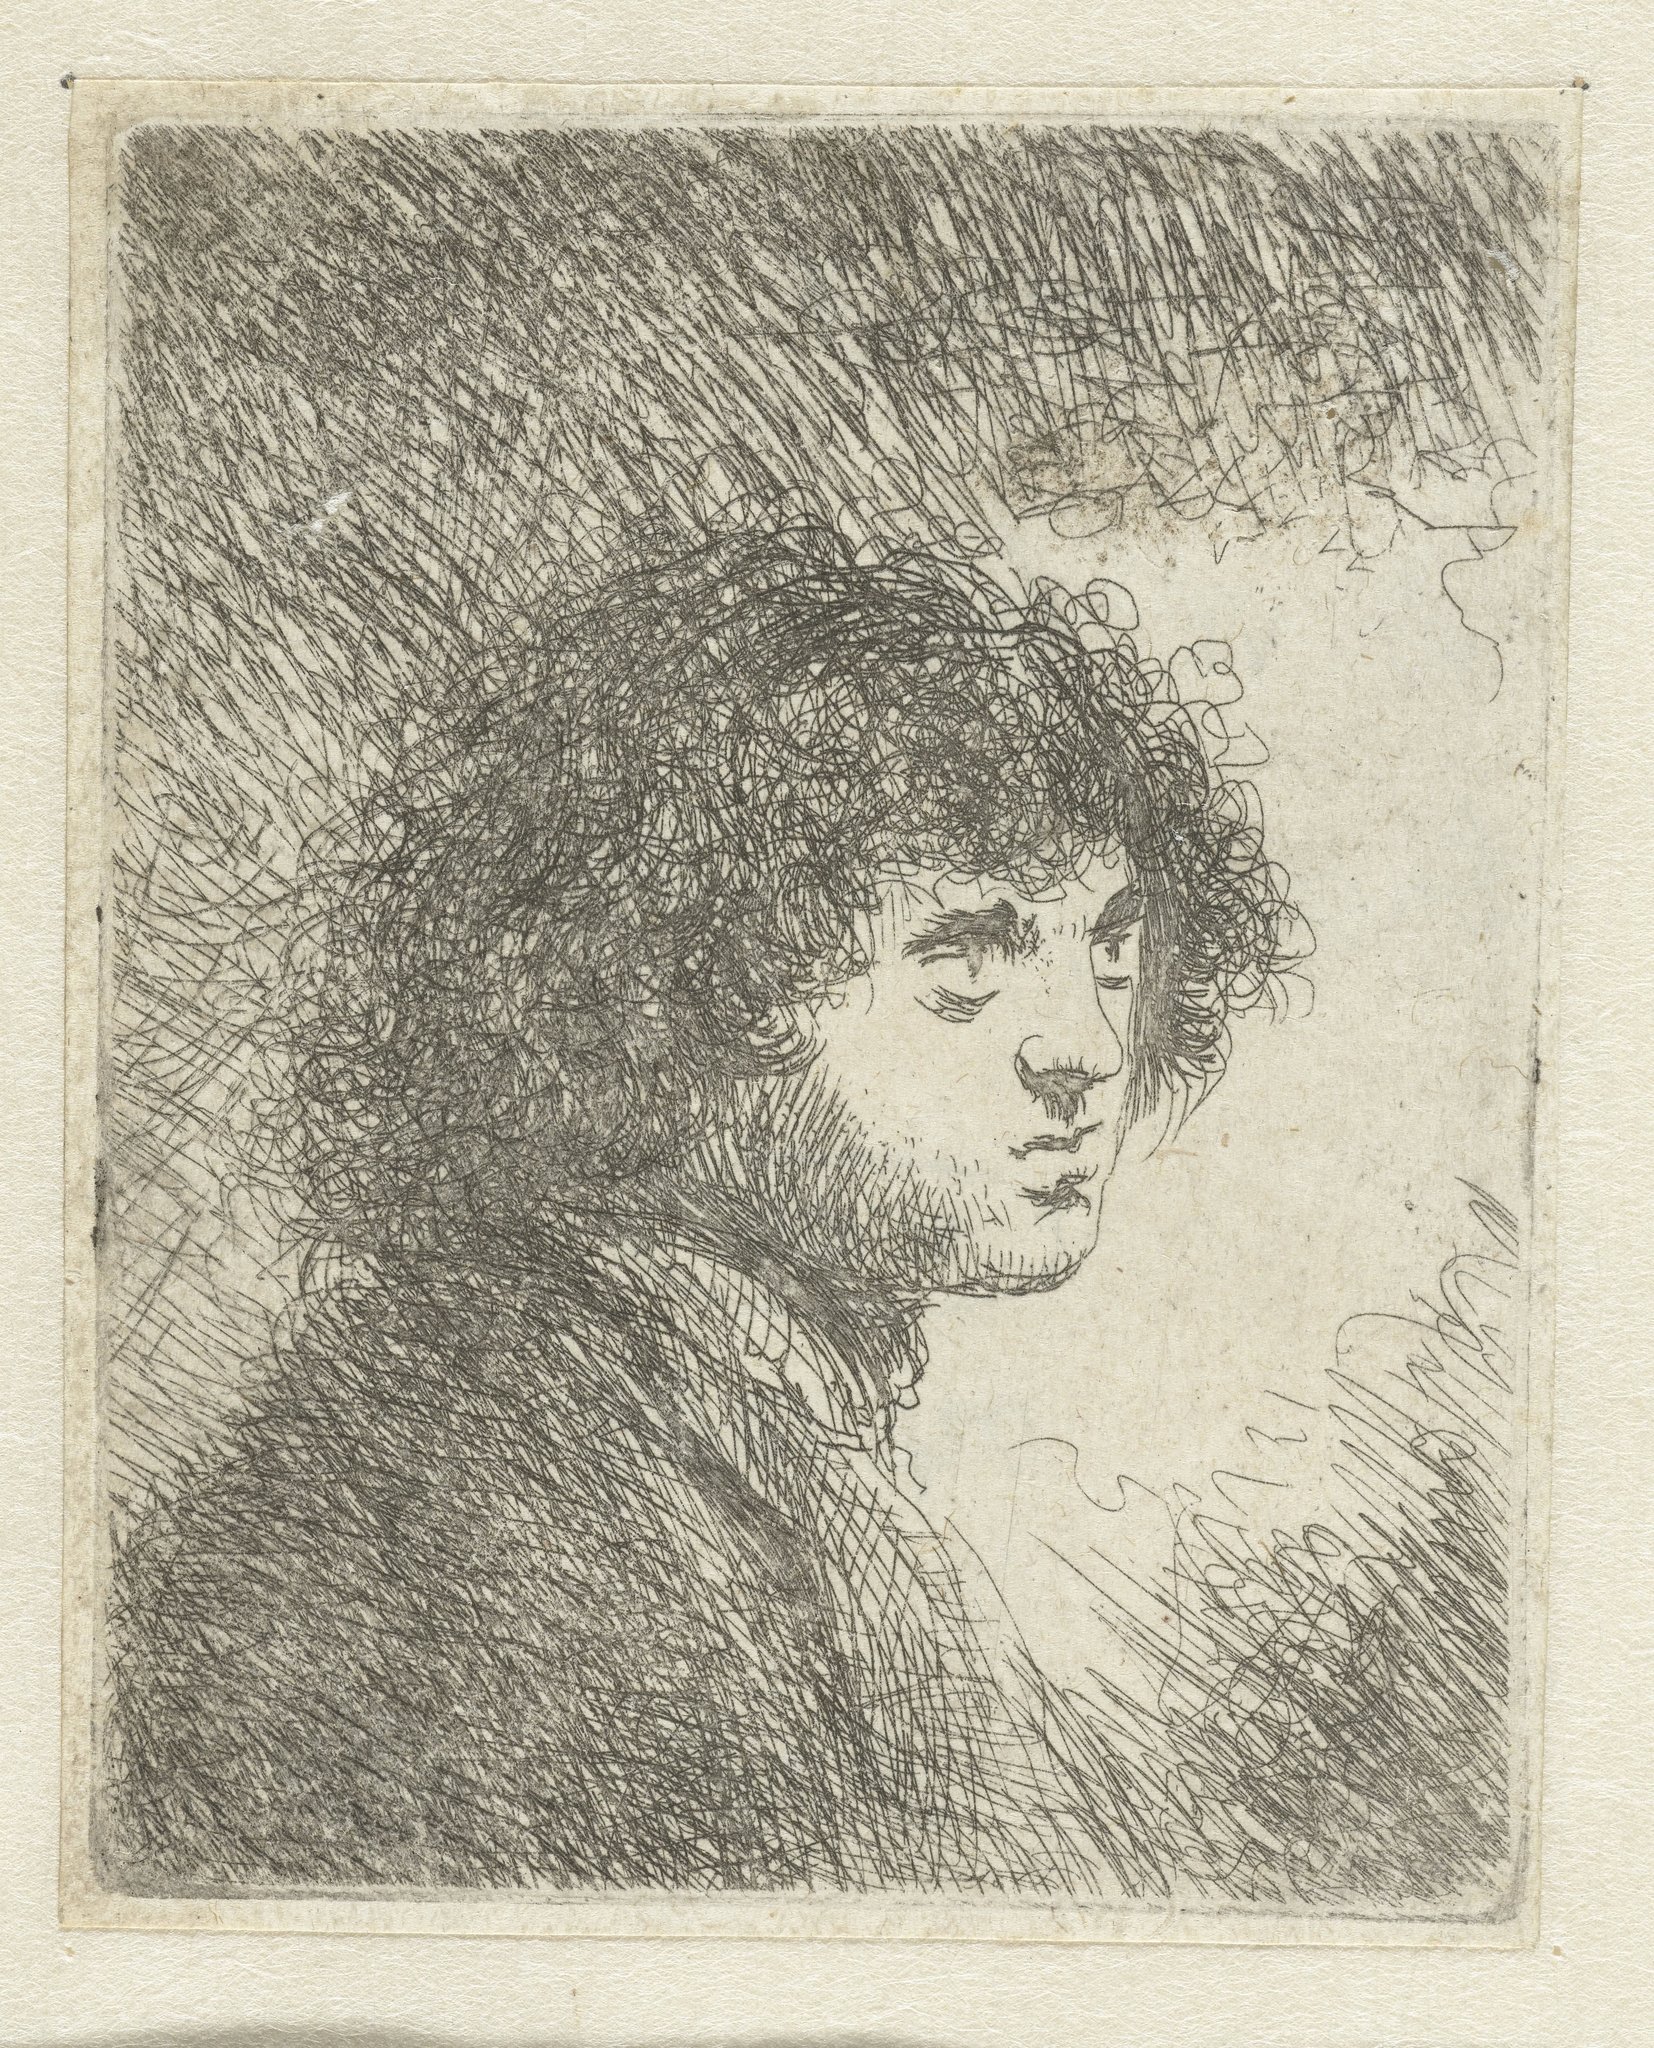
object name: print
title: Borstbeeld van een jonge man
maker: jan lievens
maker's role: draughtsman, painter, print maker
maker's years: 1607-1674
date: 1625-1674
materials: paper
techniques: etching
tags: youth, adolescent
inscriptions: collector's mark: Lugt 2228a